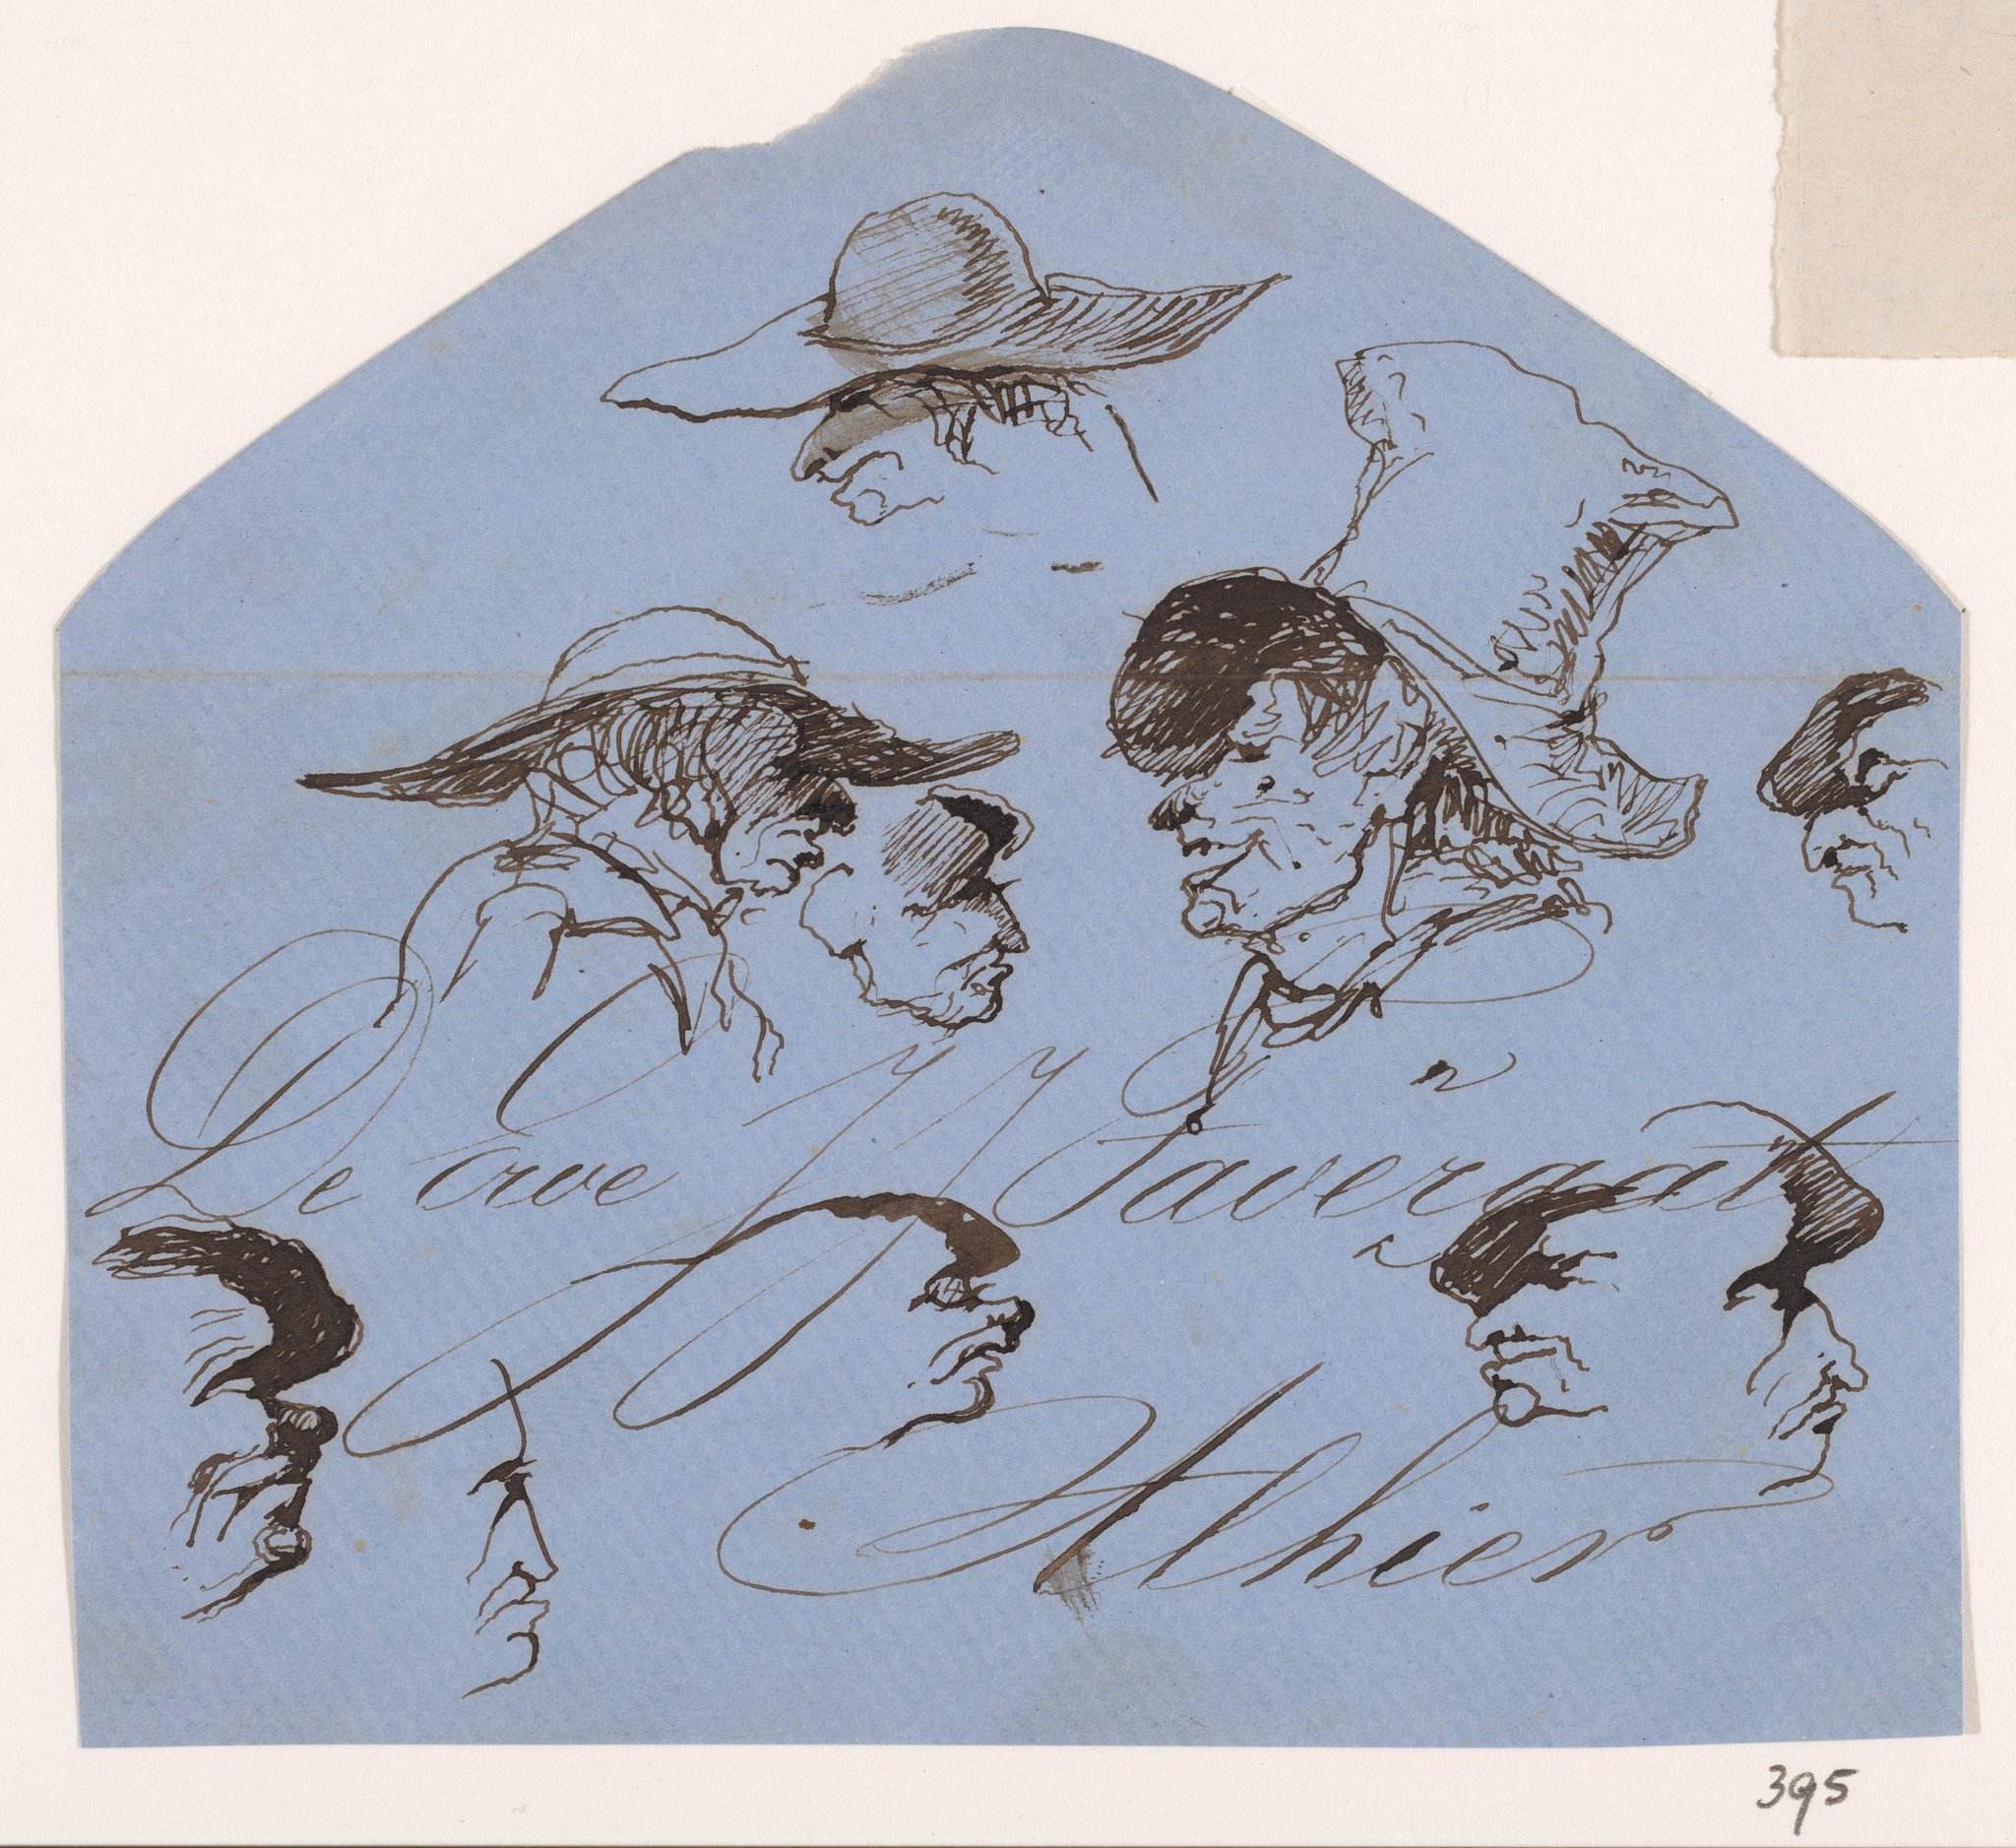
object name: drawing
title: Koppen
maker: johannes tavenraat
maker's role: draughtsman, painter, print maker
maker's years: 1809-1881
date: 1840-1880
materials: ink, paper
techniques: pen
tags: caricatures (human types)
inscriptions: collector's mark: Lugt 2228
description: Tien koppen. Getekend op een envelop gericht aan Tavenraat.